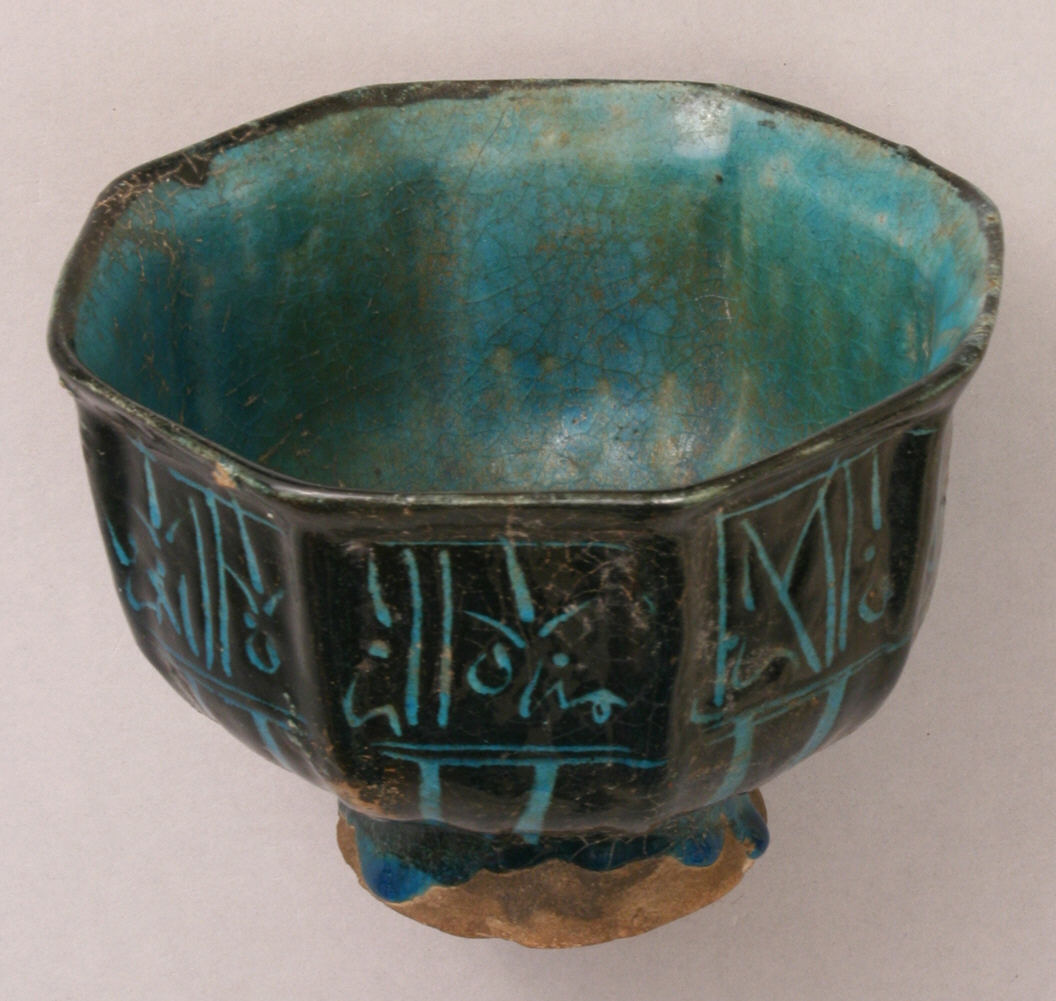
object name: bowl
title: Stonepaste Bowl with Blue and Black Underglaze Painting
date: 1167-1200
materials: stonepaste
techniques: glazing, incising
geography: iran